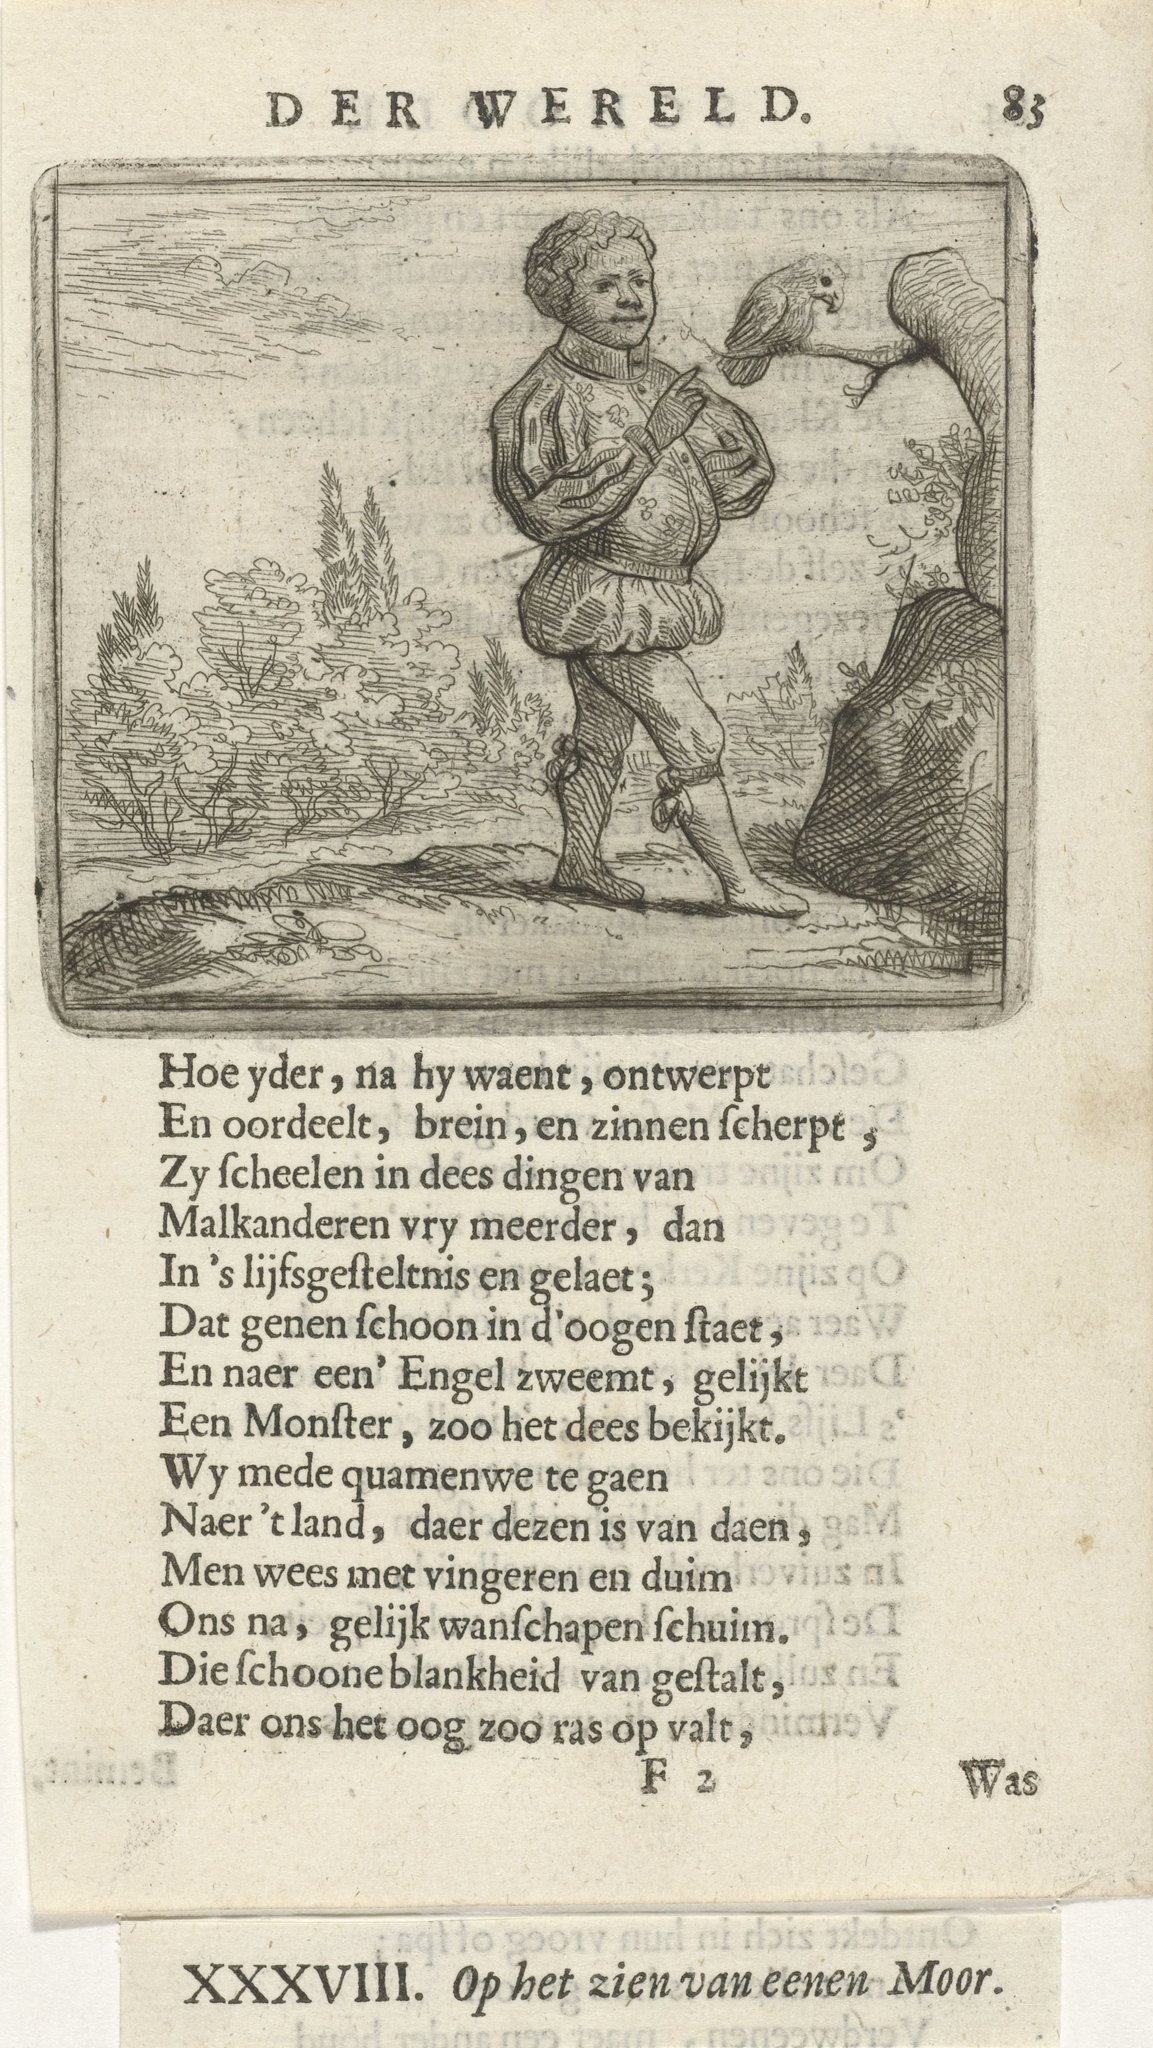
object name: book illustration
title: Zwarte man bij een vogel op een tak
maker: arnold houbraken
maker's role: draughtsman, painter, print maker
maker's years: 1660-1719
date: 1682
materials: paper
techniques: etching, letterpress printing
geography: northern netherlands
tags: birds, human races, peoples and nationalities (other than prehistoric or extinct)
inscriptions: collector's mark: Lugt 2228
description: Prent uit: Joseph Hall, [bewerkt door] François van Hoogstraeten, De schoole der wereld, geopent in CXL. vliegende bedenkingen op veelerhande voorvallende gezichten en zaeken. Dordrecht: François van Hoogstraeten, 1682. En in herdrukken in 1687 en 1725.